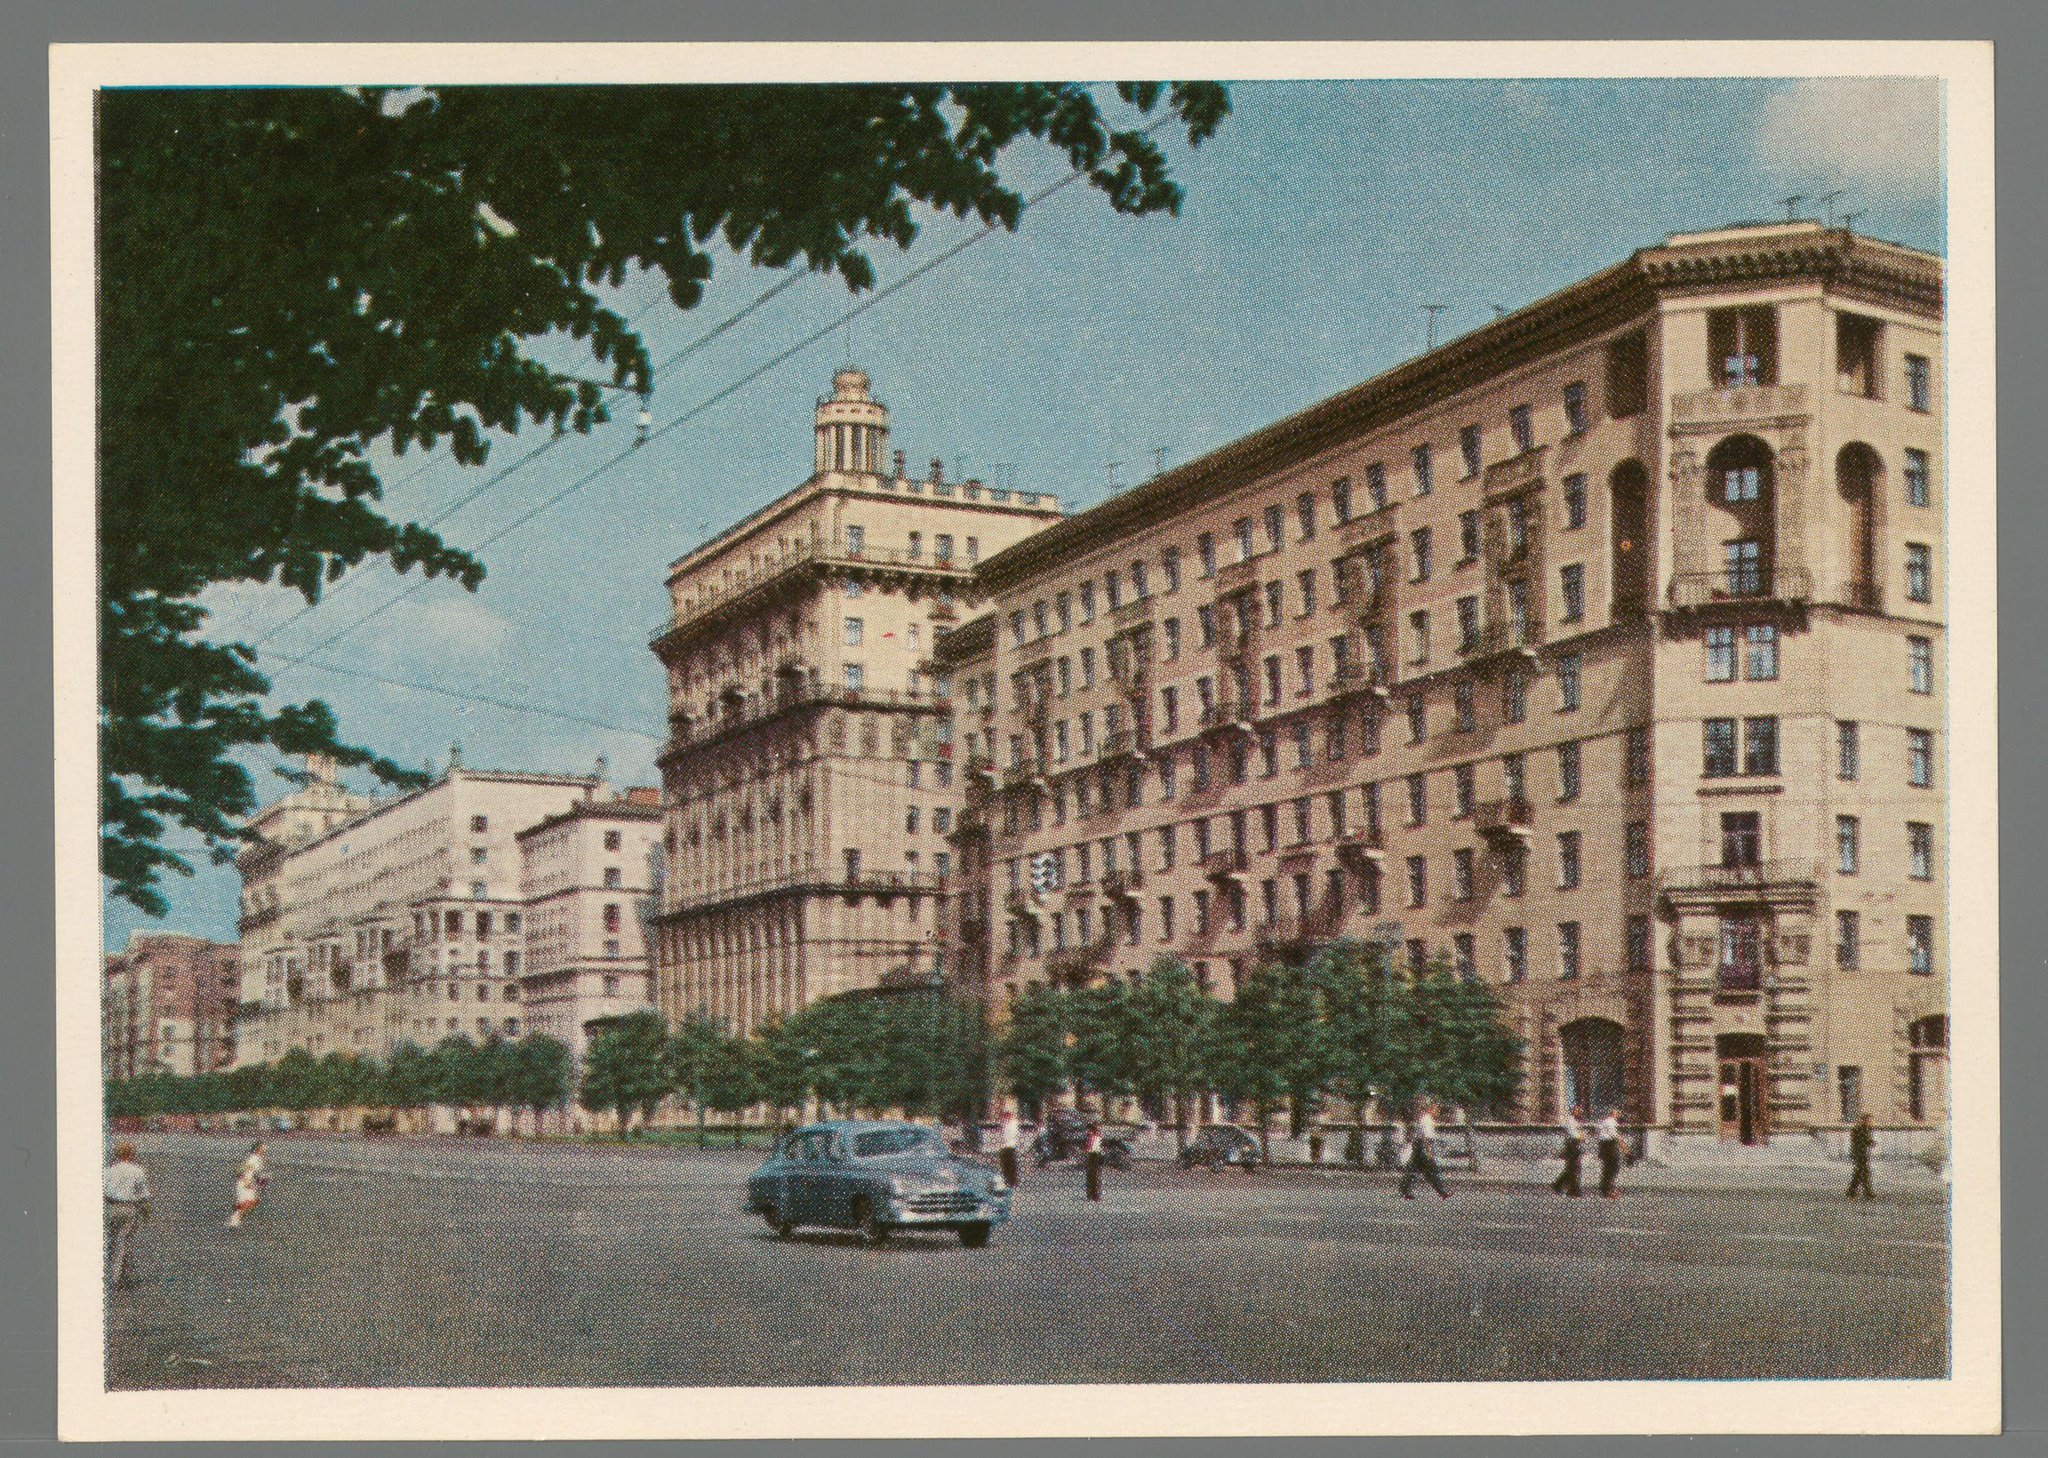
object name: ansichtkaart, prentbriefkaart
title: Moscow. Mozhaisk Highway / Moskau. Moshaisker Chaussee / Moscou. Chaussée de Mojaïsk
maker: Anonymous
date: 1956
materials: cardboard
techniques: color autotype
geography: moscow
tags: public road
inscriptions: date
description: De titel op object staat ook in het Russisch.